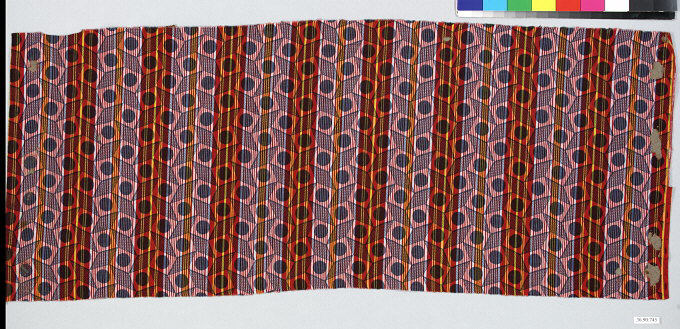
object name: piece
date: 1867-1900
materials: cotton